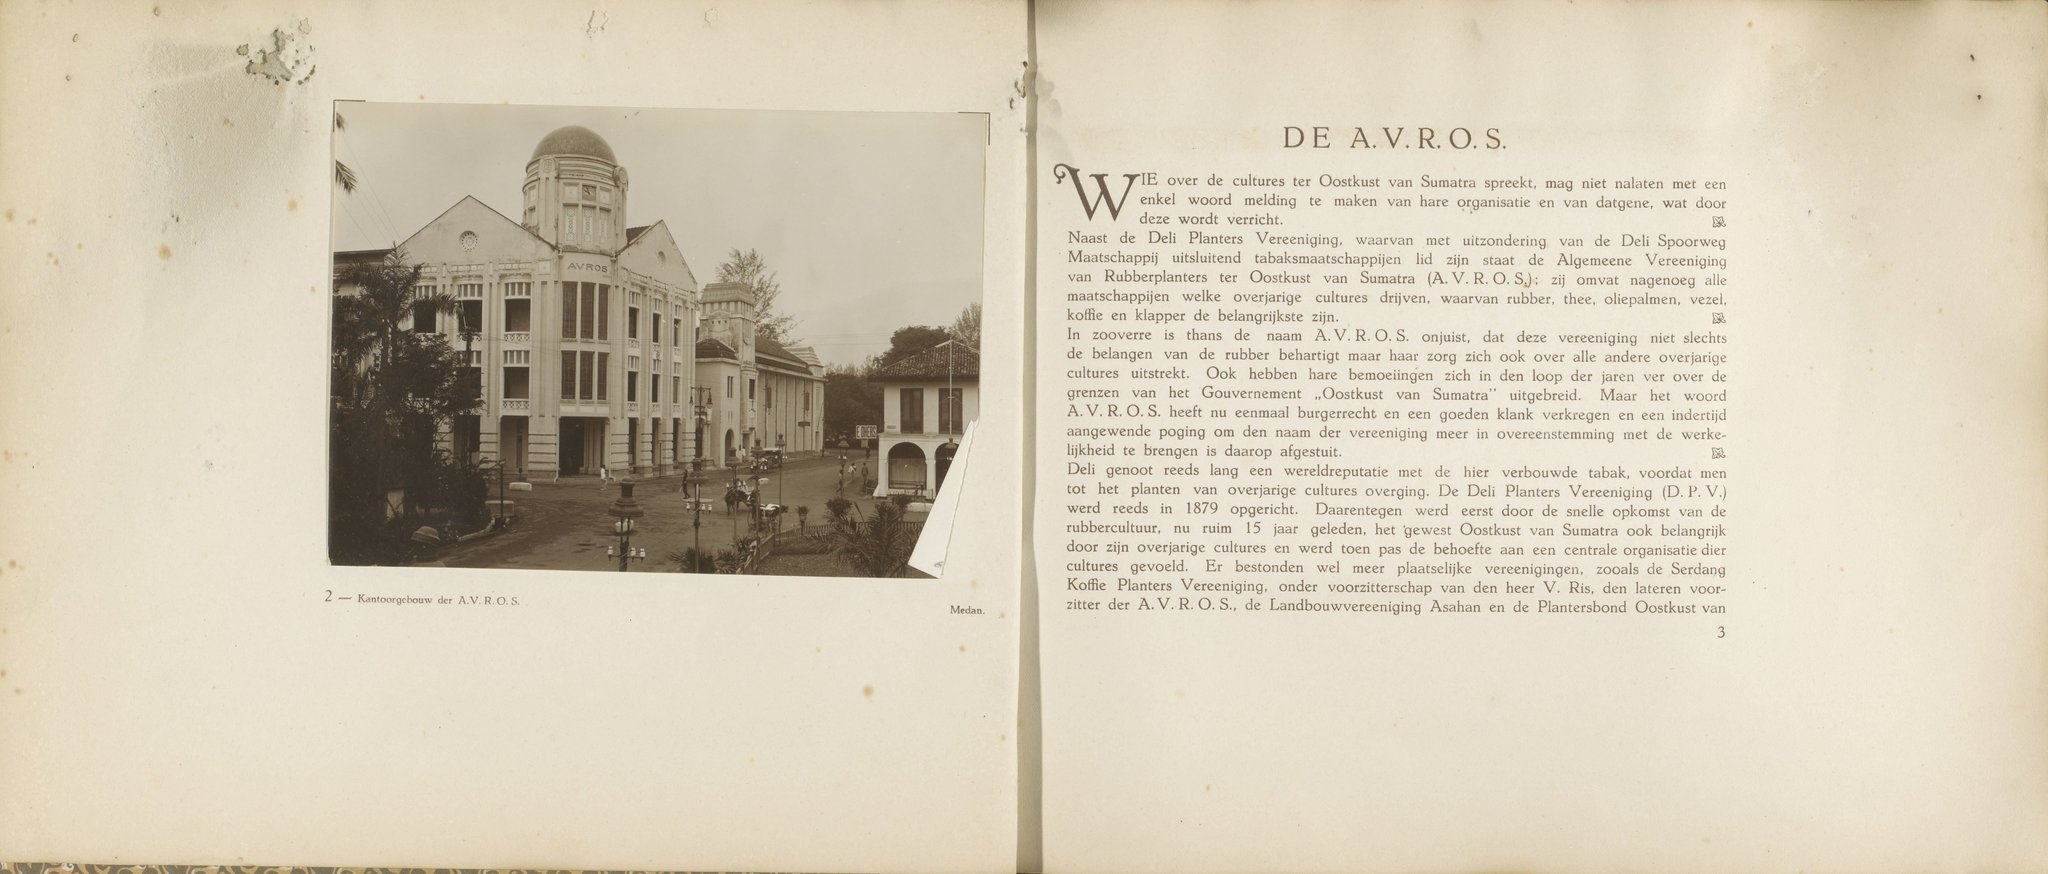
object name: photograph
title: Pagina 2 en 3 van fotoboek van de Algemeene Vereeniging van Rubberplanters ter Oostkust van Sumatra (A.V.R.O.S.)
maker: j.w. meyster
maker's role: fotograaf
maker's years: 1887-1945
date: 1924-1925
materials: paper, photographic support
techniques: printing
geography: medan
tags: (non-fruit) products of plants or trees: rubber, civic architecture; edifices; dwellings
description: Twee boekpagina's met links een foto van een kantoorgebouw van de A.V.R.O.S. te Medan en rechts informatie over het ontstaan van deze vereniging. Onderdeel van een fotoboek van de Algemeene Vereeniging van Rubberplanters ter Oostkust van Sumatra (A.V.R.O.S.).